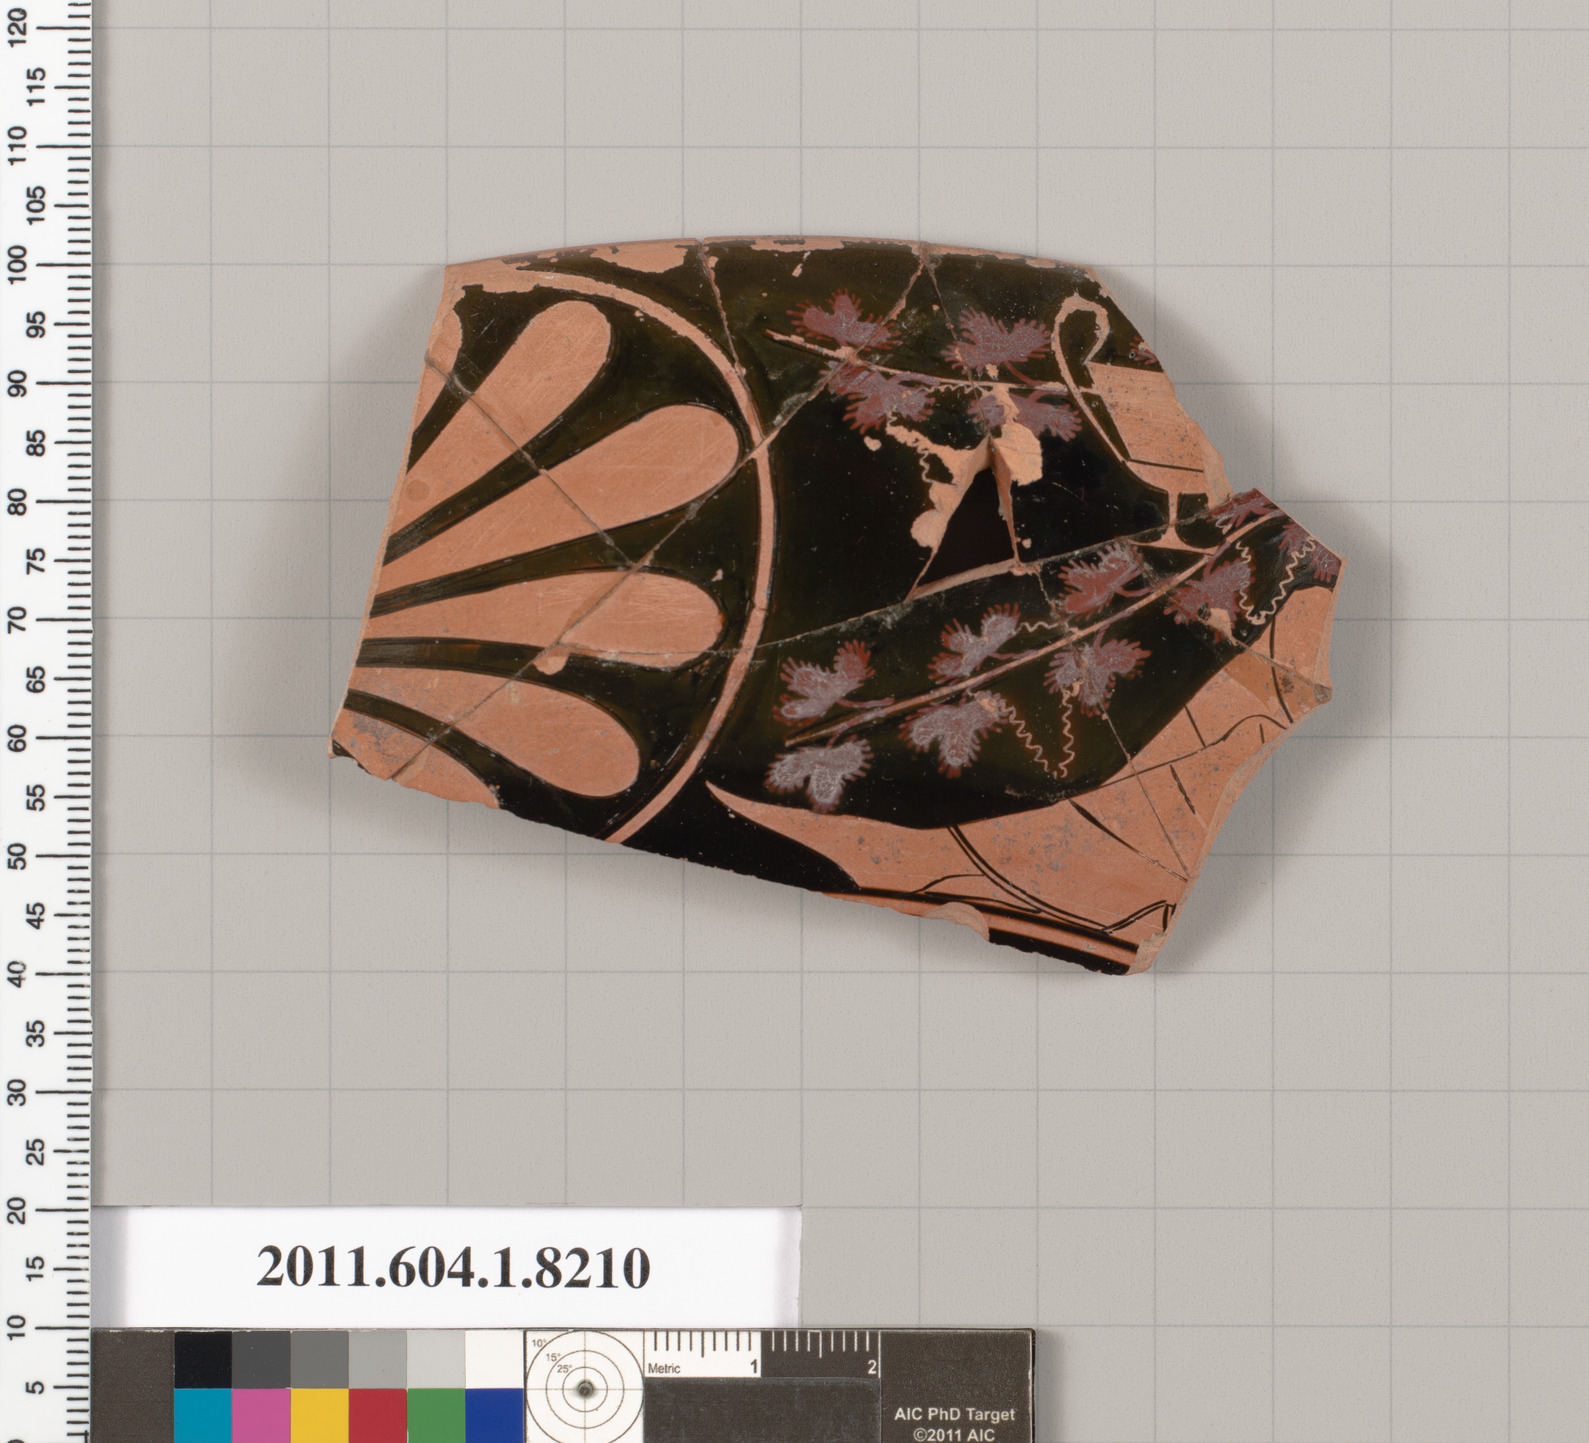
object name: kylix fragment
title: Terracotta rim fragment of a kylix (drinking cup)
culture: greek, attic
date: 520-510 BCE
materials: terracotta